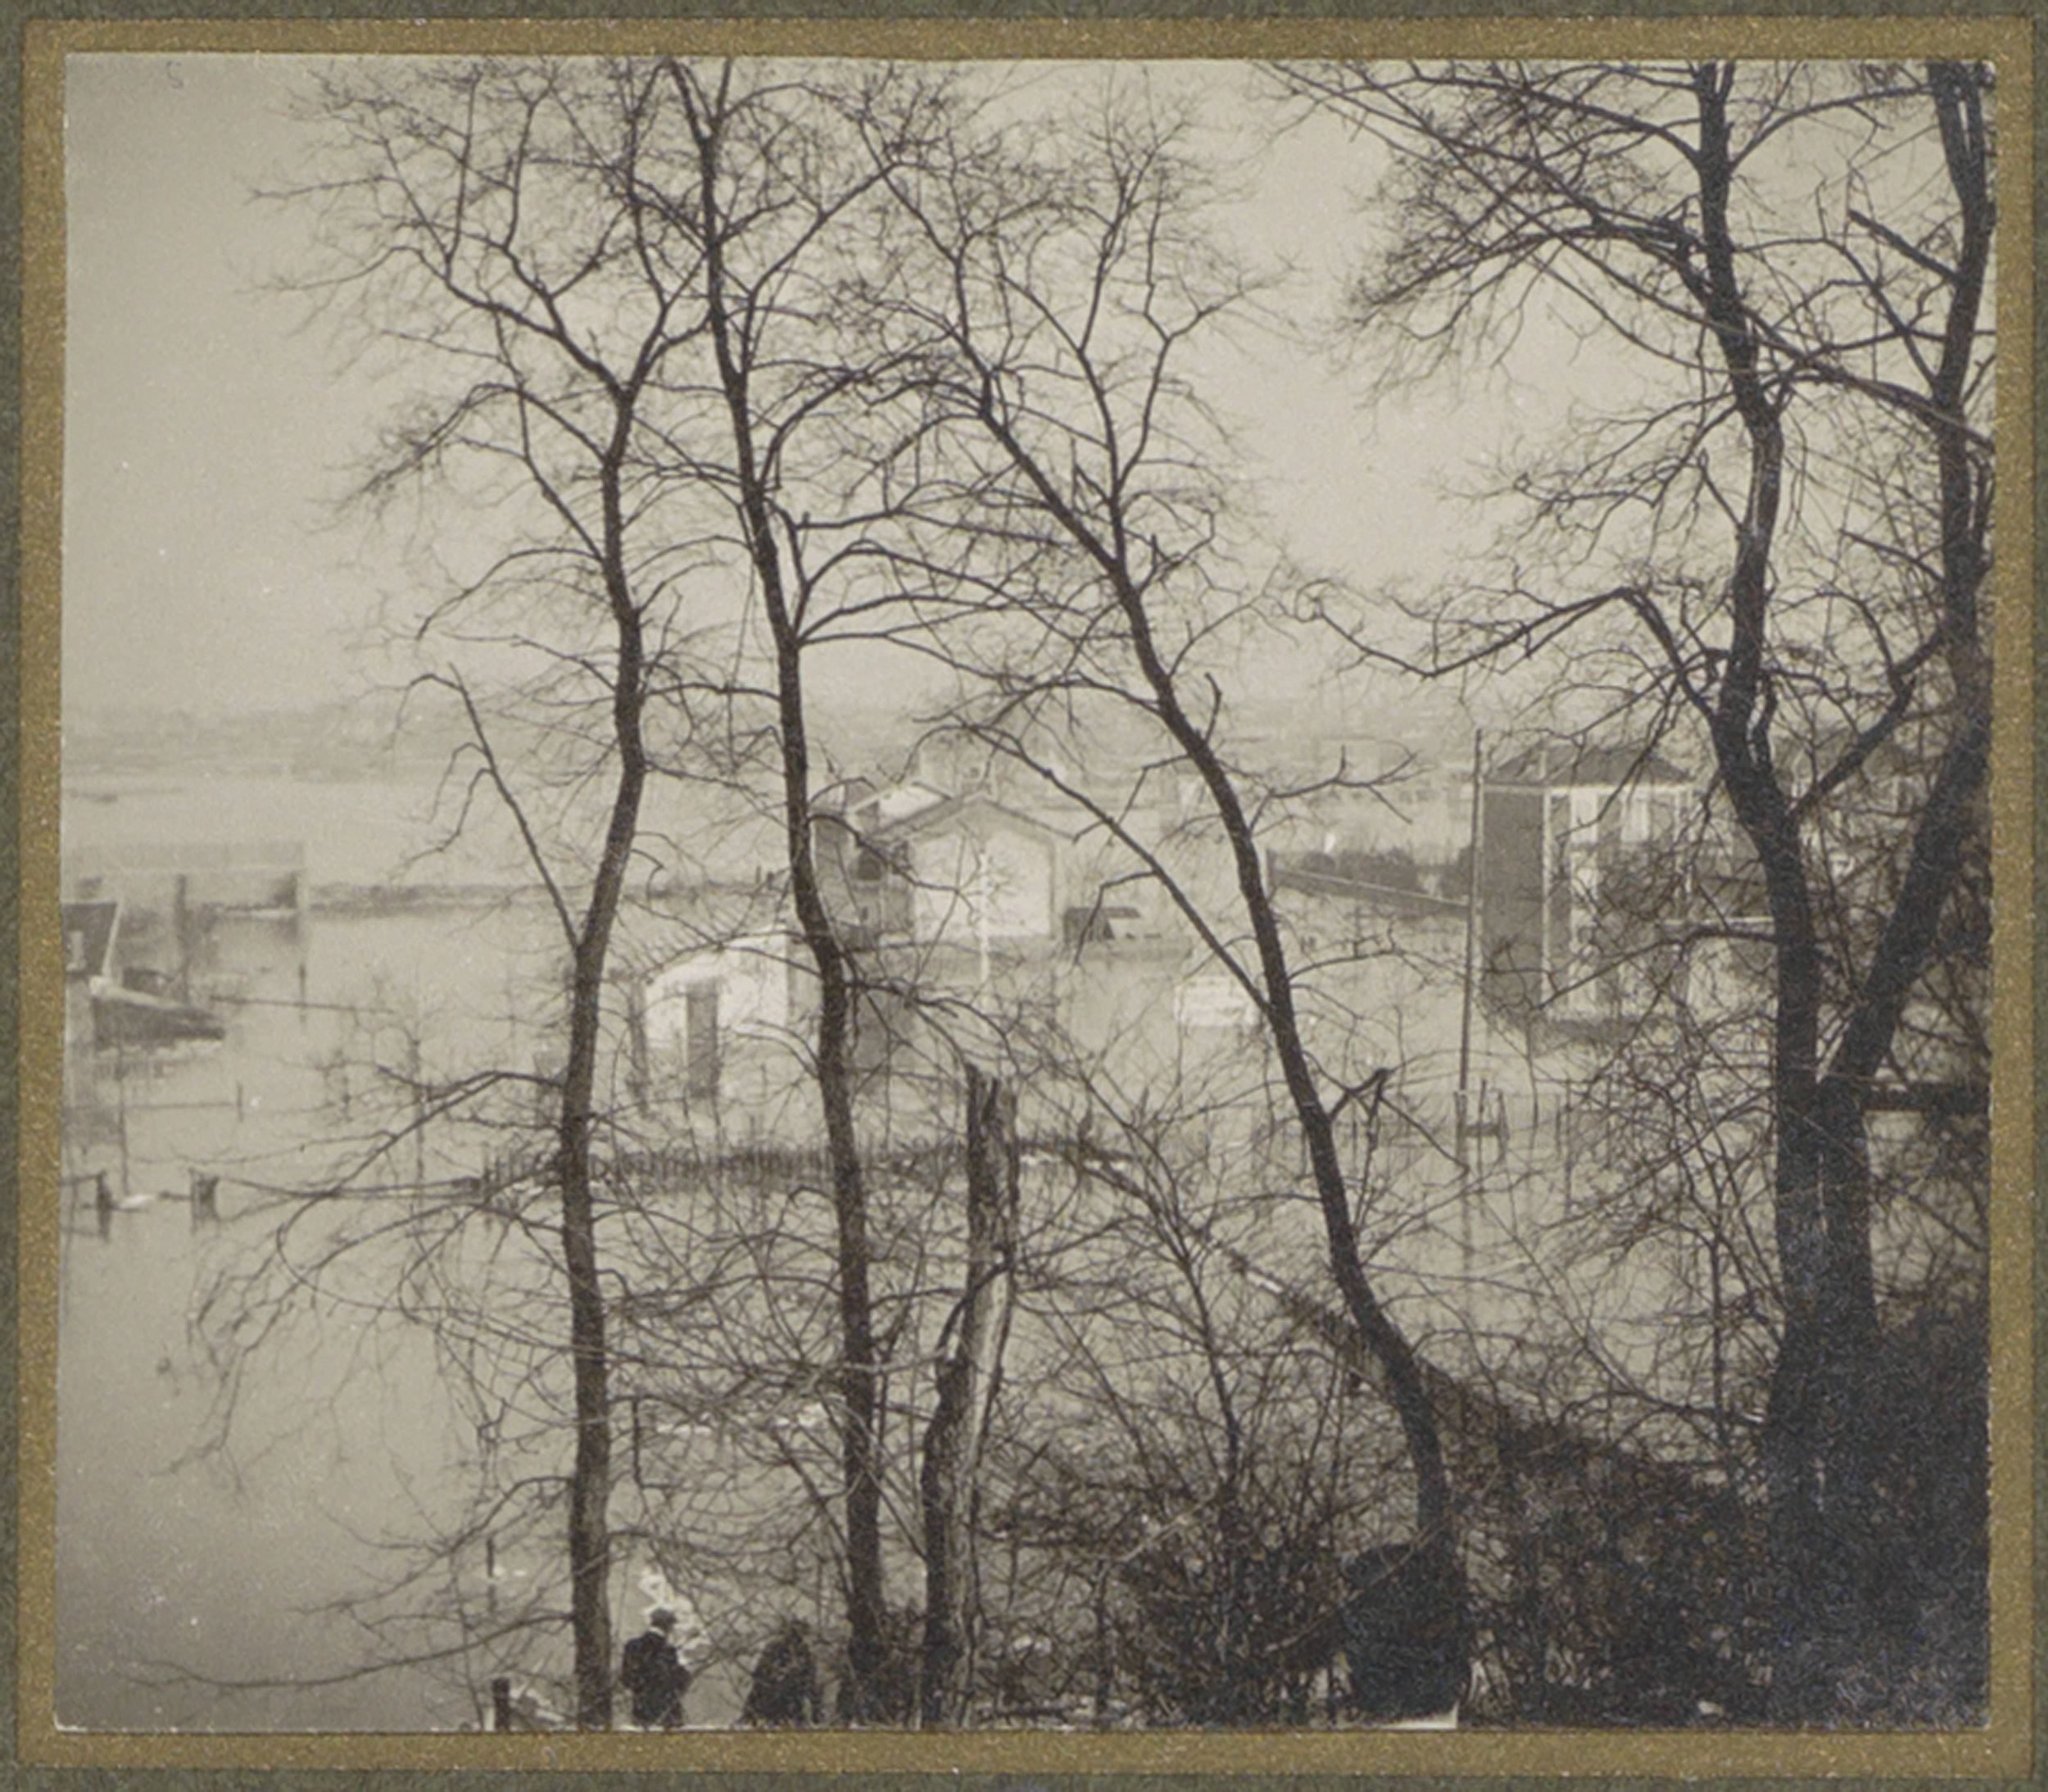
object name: photograph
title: Huizen in ondergelopen buitenwijk van Parijs gezien door kale bomen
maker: g. dangereux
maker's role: fotograaf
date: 1901-1910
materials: photographic support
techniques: matte daylight collodion silver print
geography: paris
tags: flood (+ landscape with figures, staffage), paris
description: Onderdeel van fotoalbum overstroming Parijs en voorsteden 1910.